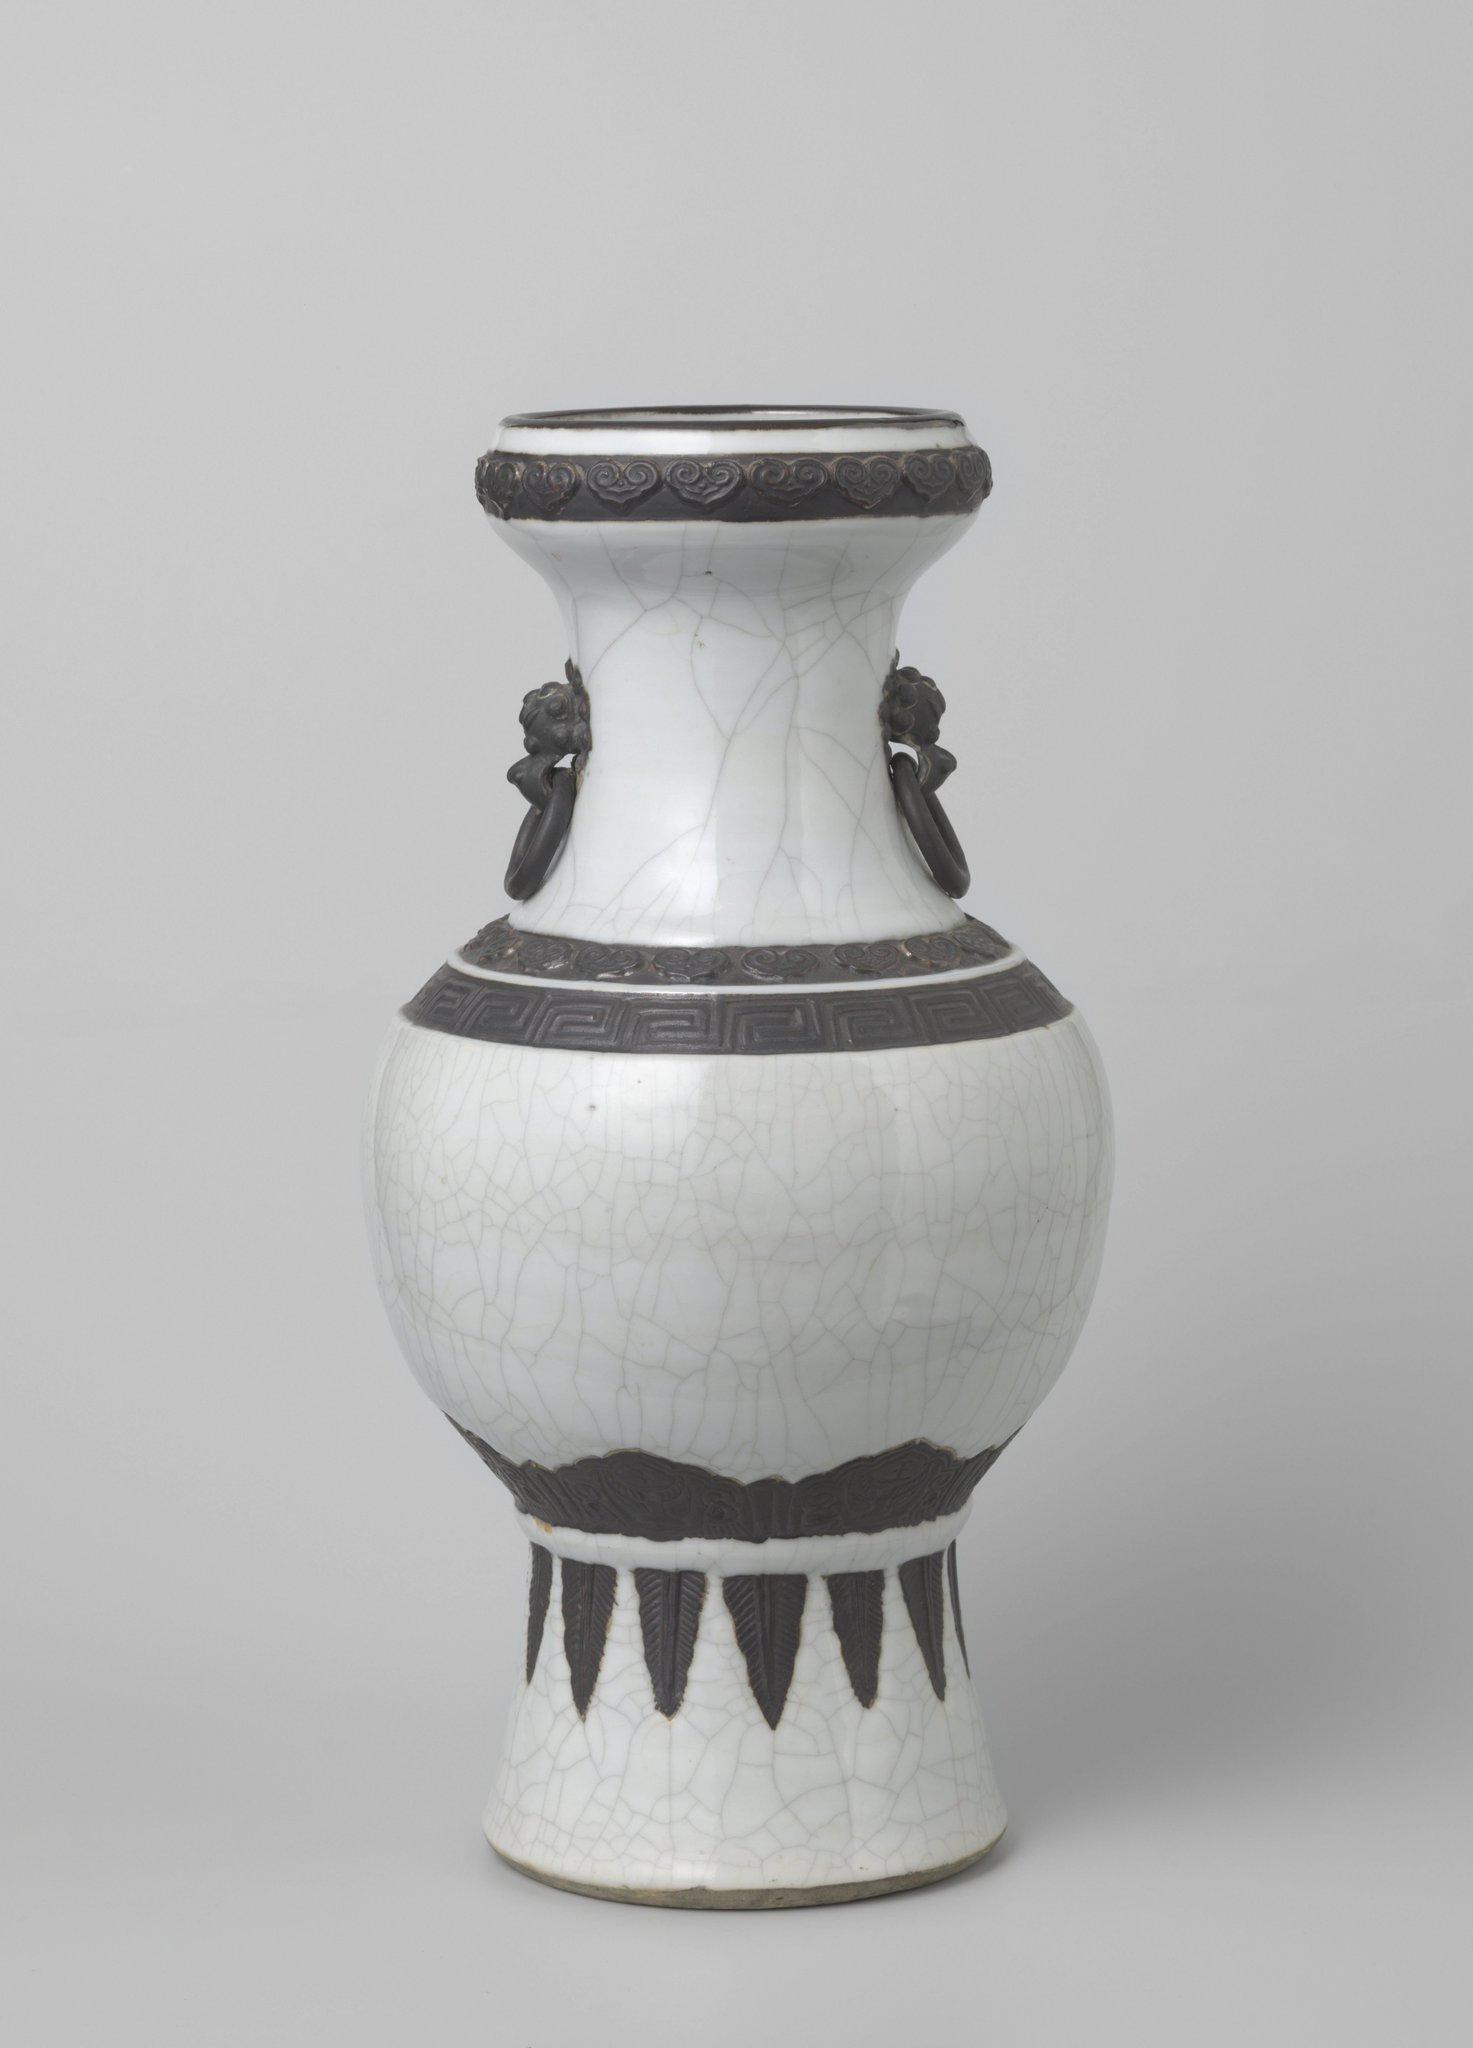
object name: vase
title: Vase with ornamental borders and lion heads with ring handles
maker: Anonymous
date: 1800-1900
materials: paint, glaze, porcelain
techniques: firing, turning, vitrification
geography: china